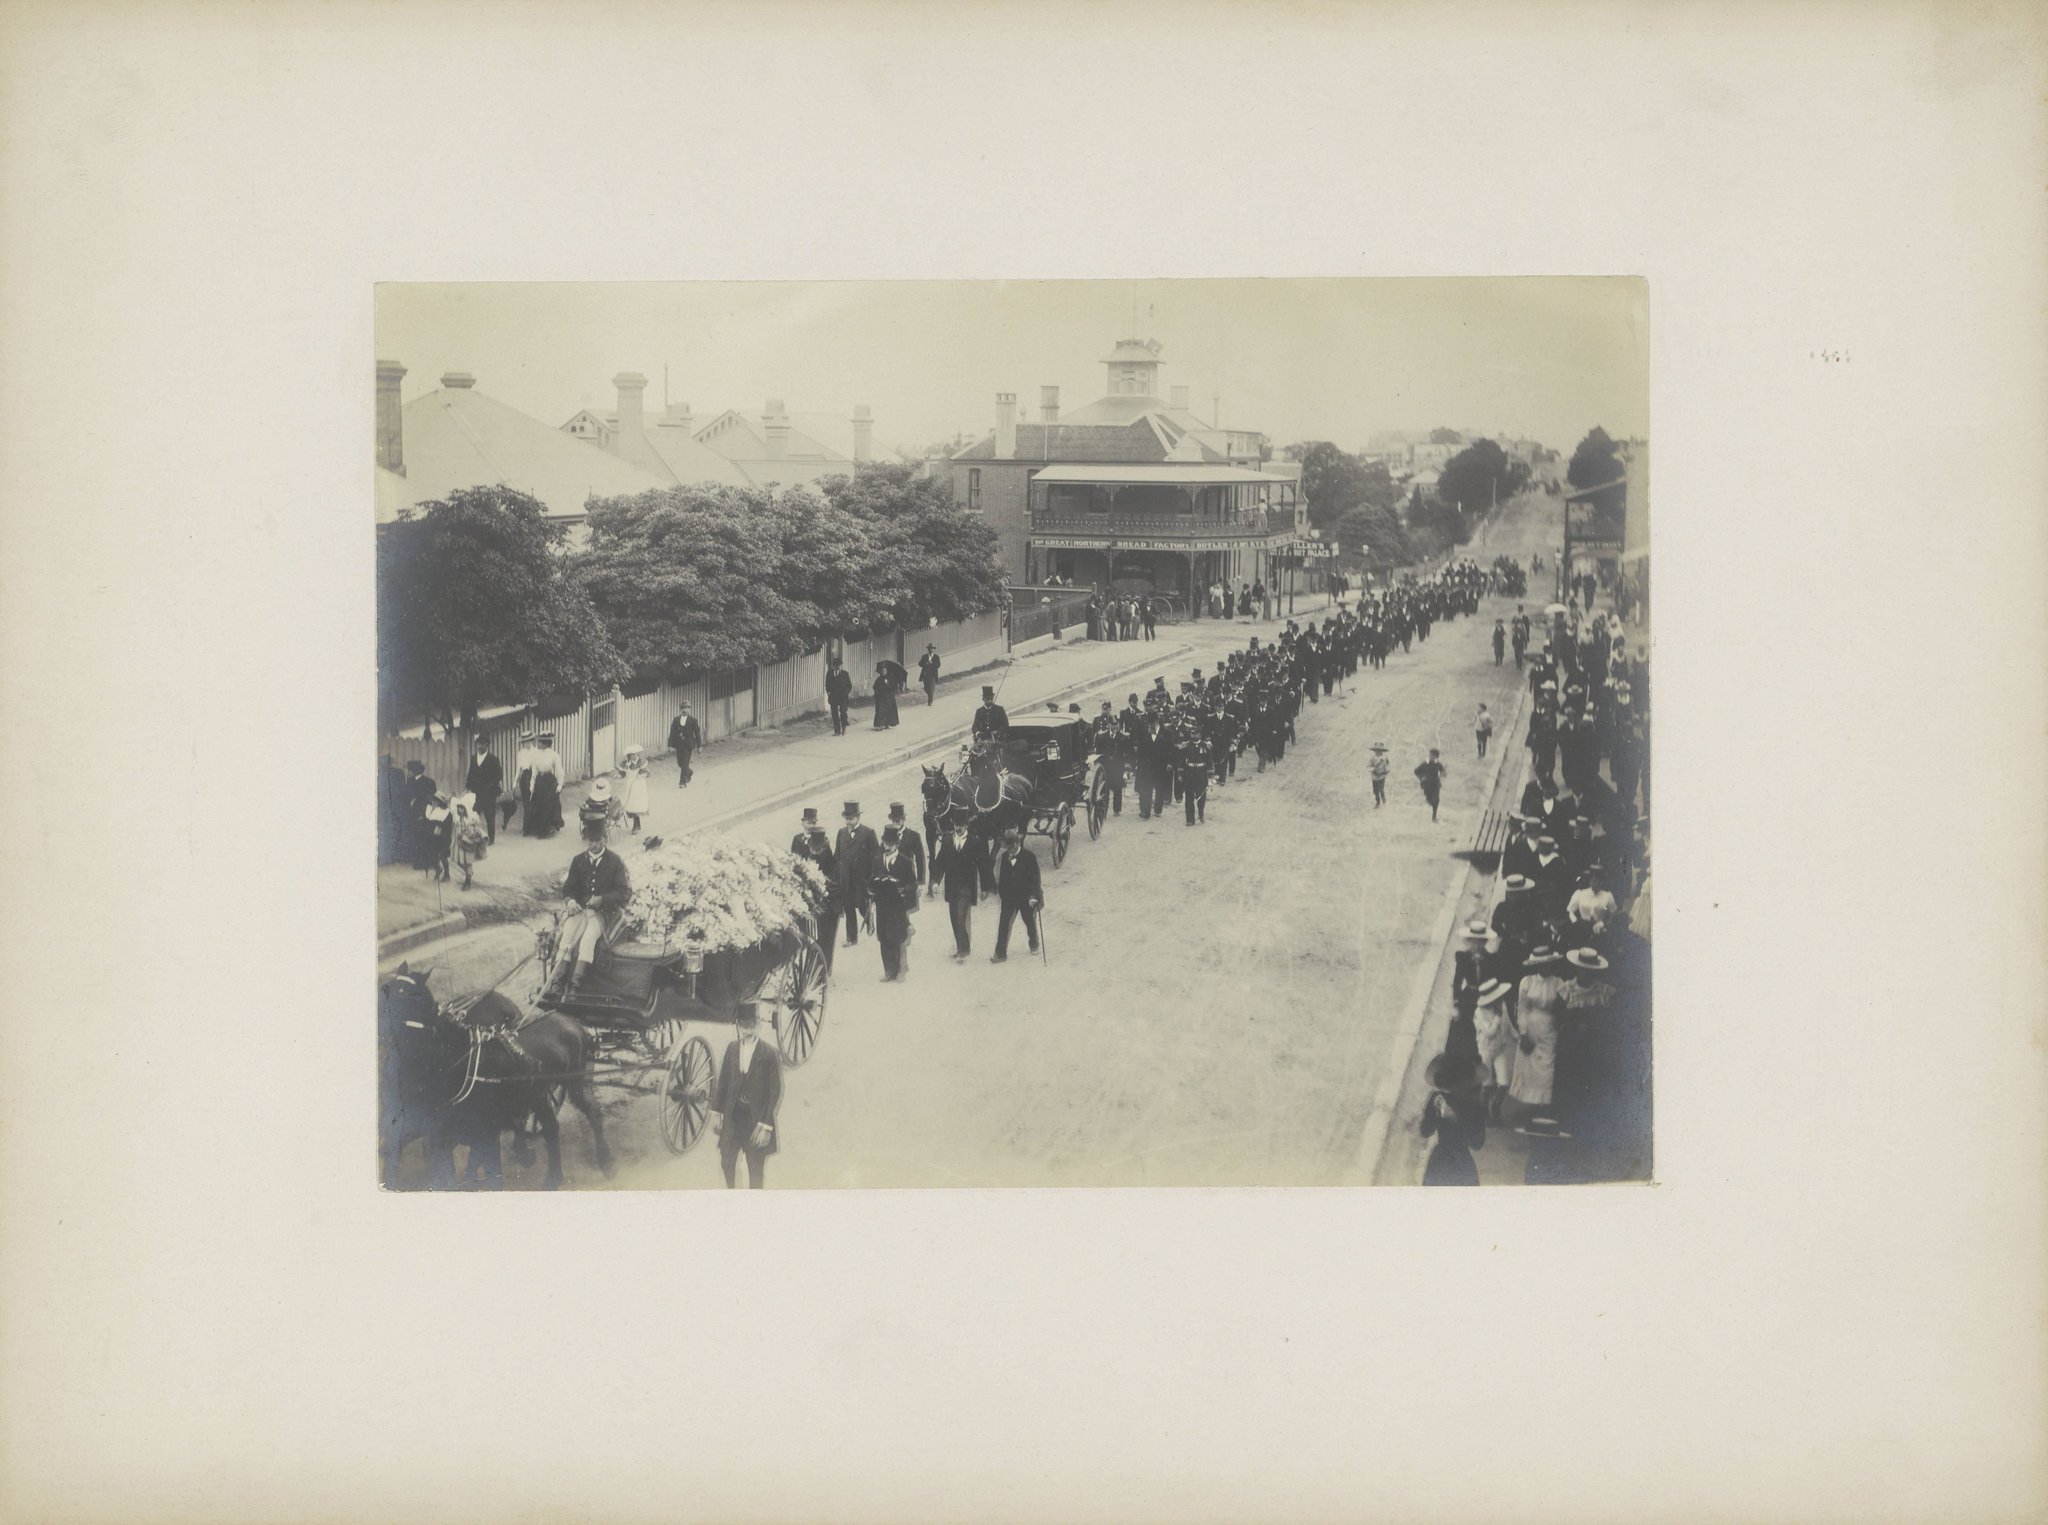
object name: album leaf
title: Funeral procession for the Consul General for Germany to Australia, Herr Peter F. Hermannkamp, in Sydney on 7 November 1900.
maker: Anonymous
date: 1900-1910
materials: cardboard, paper, photographic support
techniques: gelatin silver print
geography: sydney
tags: cortege, funeral procession, military parade, pageant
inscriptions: inscription: ‘uit map met foto's van Sydney gekocht Waterlooplein Amsterdam 1963 à f 0,10’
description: Onderdeel van Reisalbum met foto's van bezienswaardigheden in Sydney. Begrafenisstoet voor de Duitse consul-generaal, de heer Peter F. Hermannkamp, te Sydney op 7 november 1900. De processie loopt door West Street in noord Sydney, vlakbij de begraafplaats.